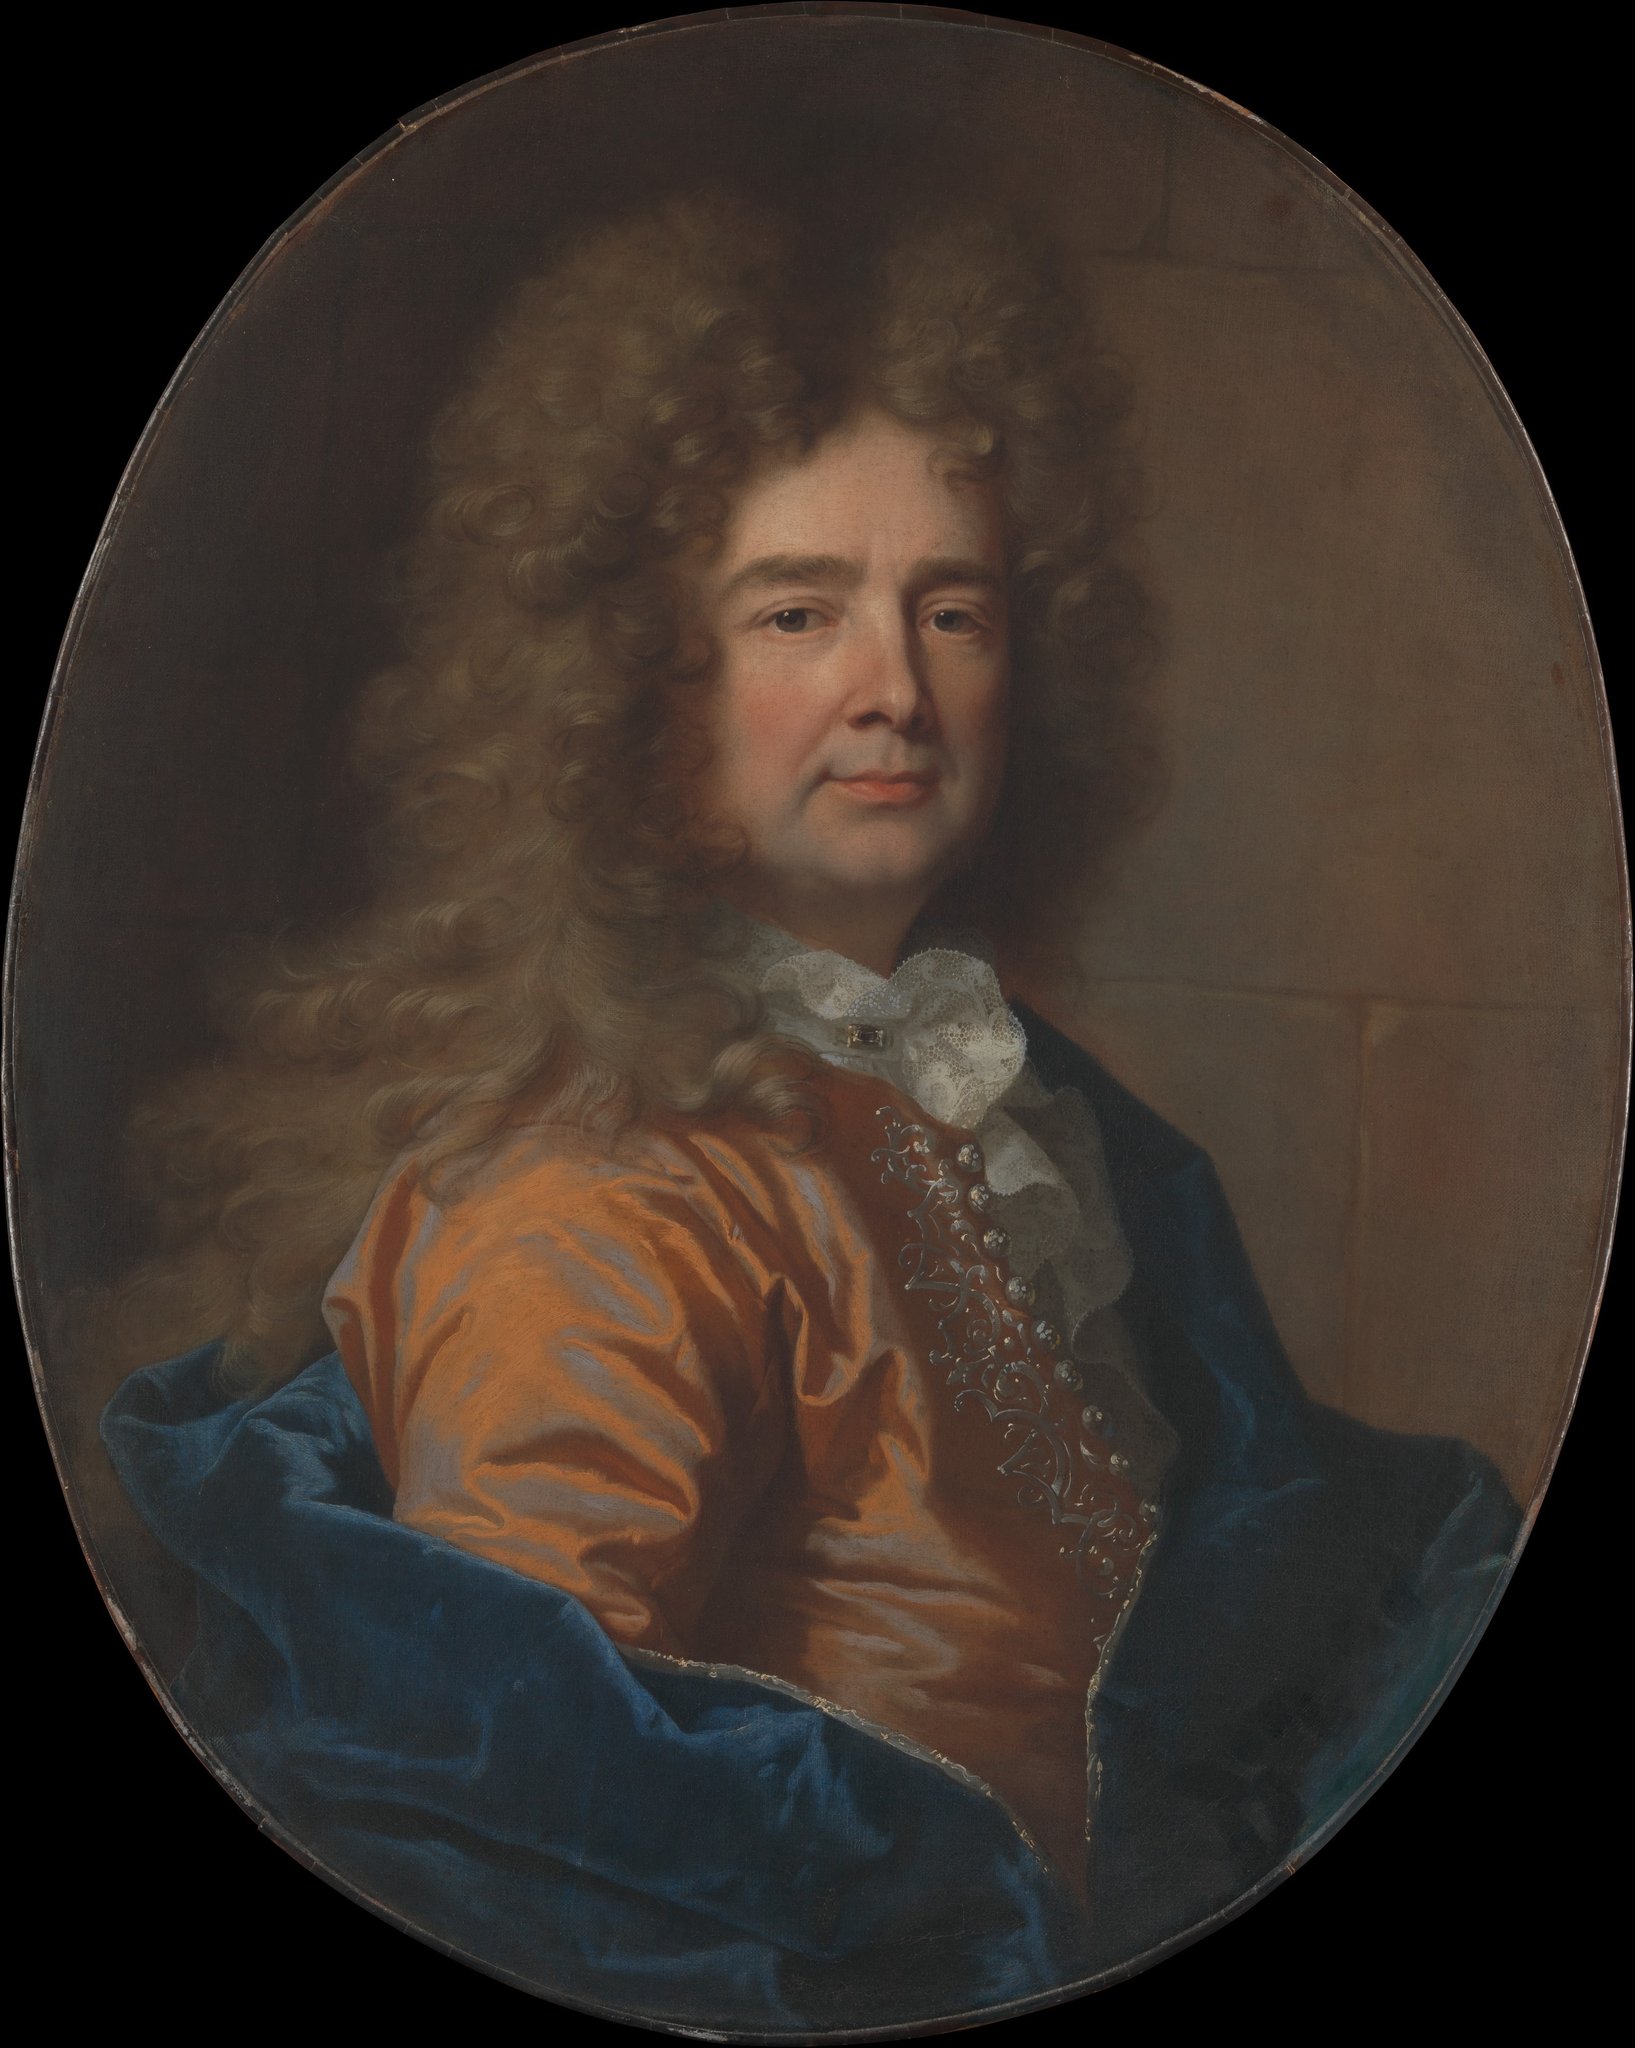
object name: painting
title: Portrait of a Man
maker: hyacinthe rigaud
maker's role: artist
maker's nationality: french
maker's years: 1659-1743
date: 1693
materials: canvas, oil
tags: men,portraits